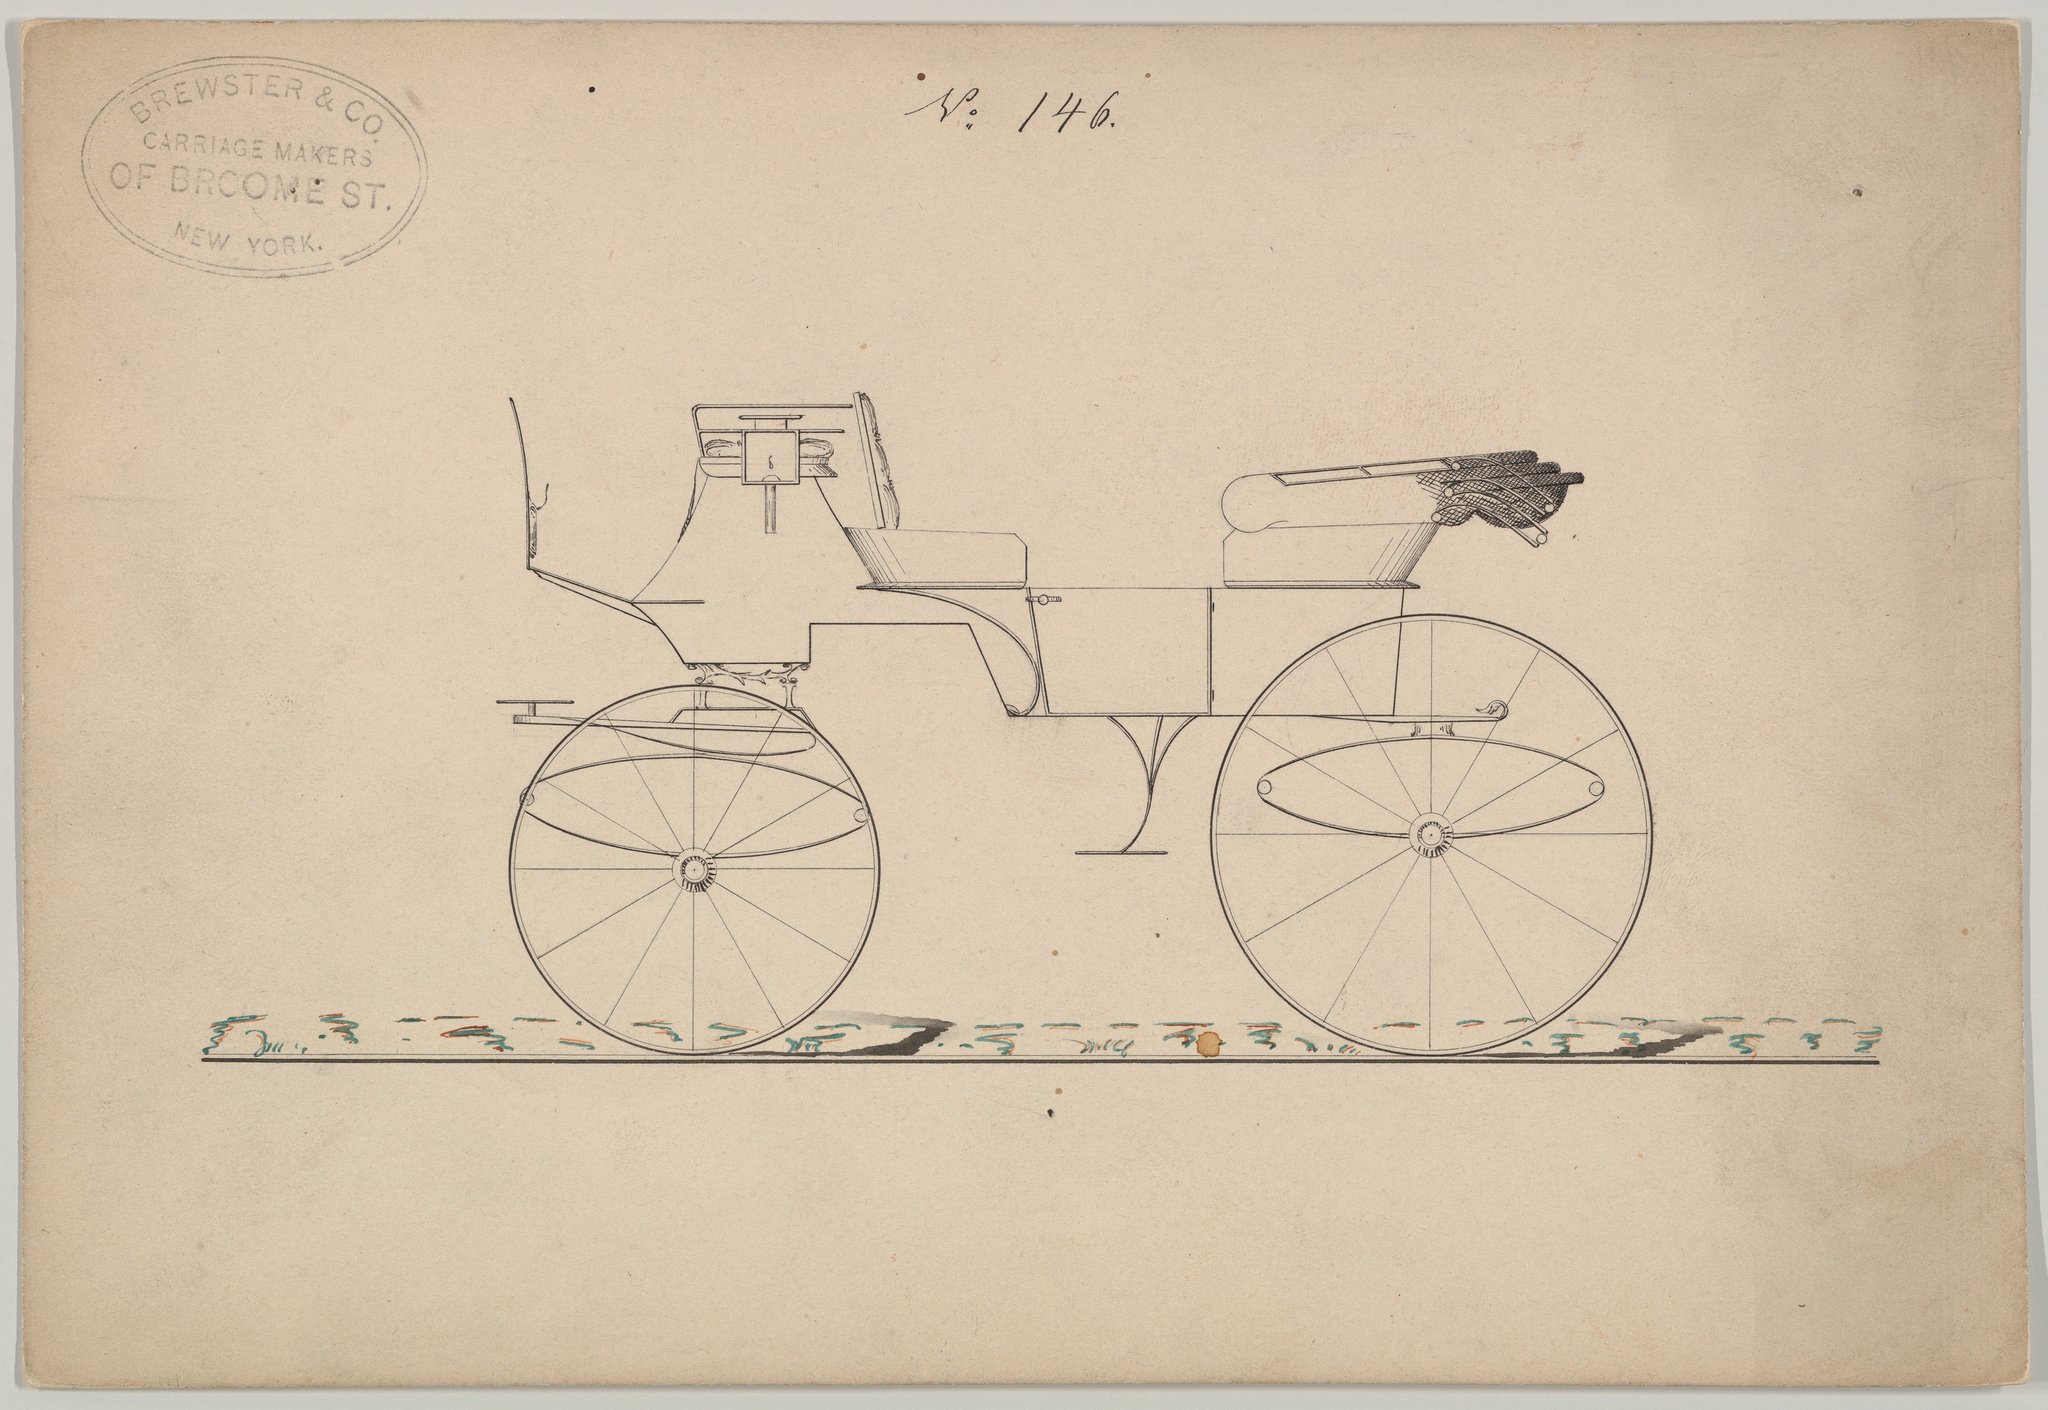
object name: drawing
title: Design for Char-a-banc/Phaeton, no. 146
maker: brewster & co.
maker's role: manufacturer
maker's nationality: american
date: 1850-1874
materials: gouache, ink, watercolor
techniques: pen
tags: carriages